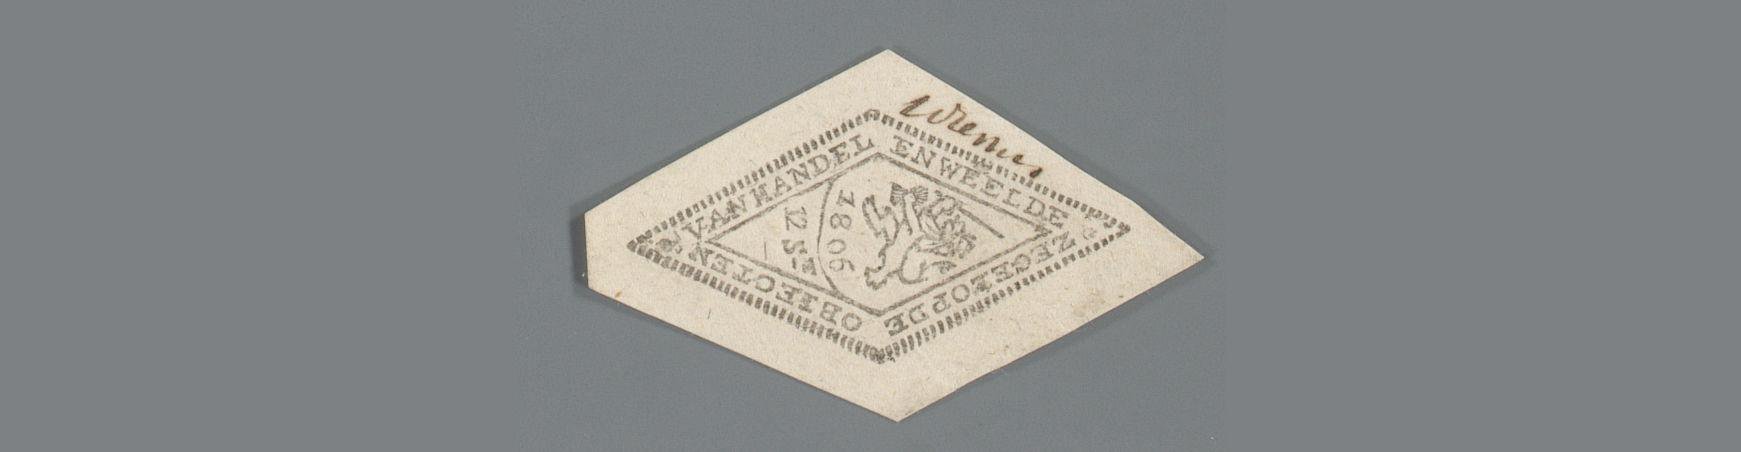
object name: print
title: Belastingzegel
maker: Anonymous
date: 1806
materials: paper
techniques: woodcut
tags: taxes and financial administration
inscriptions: inscription: ‘[...]’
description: Een voorstel van Alexander Gogel, minister van Financiën, voor een zegelbelasting op luxe artikelen werd in 1805 aangenomen. Als bewijs van betaling werd een zegeltje geplakt op bijvoorbeeld hoeden, paraplu's, handschoenen en waaiers.